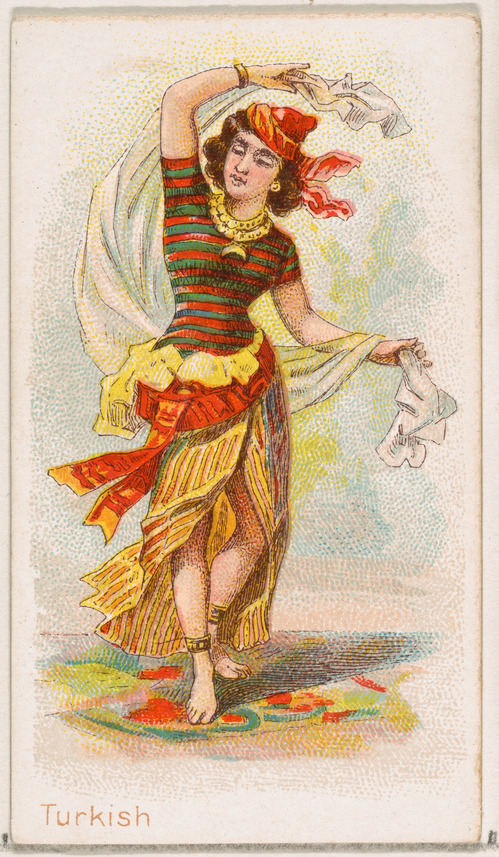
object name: print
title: Turkish Dancer, from the Dancing Women series (N186) issued by Wm. S. Kimball & Co.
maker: william s. kimball & company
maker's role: publisher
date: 1889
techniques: color lithograph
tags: dance,women,dancing